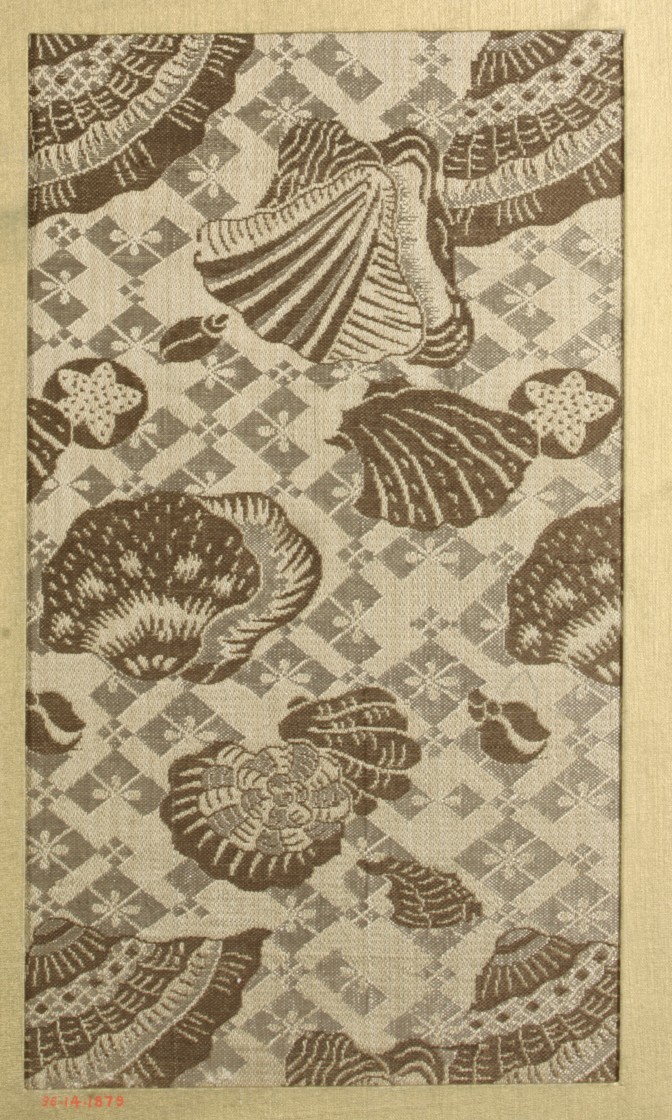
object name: piece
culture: japanese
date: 1701-1900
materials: silk